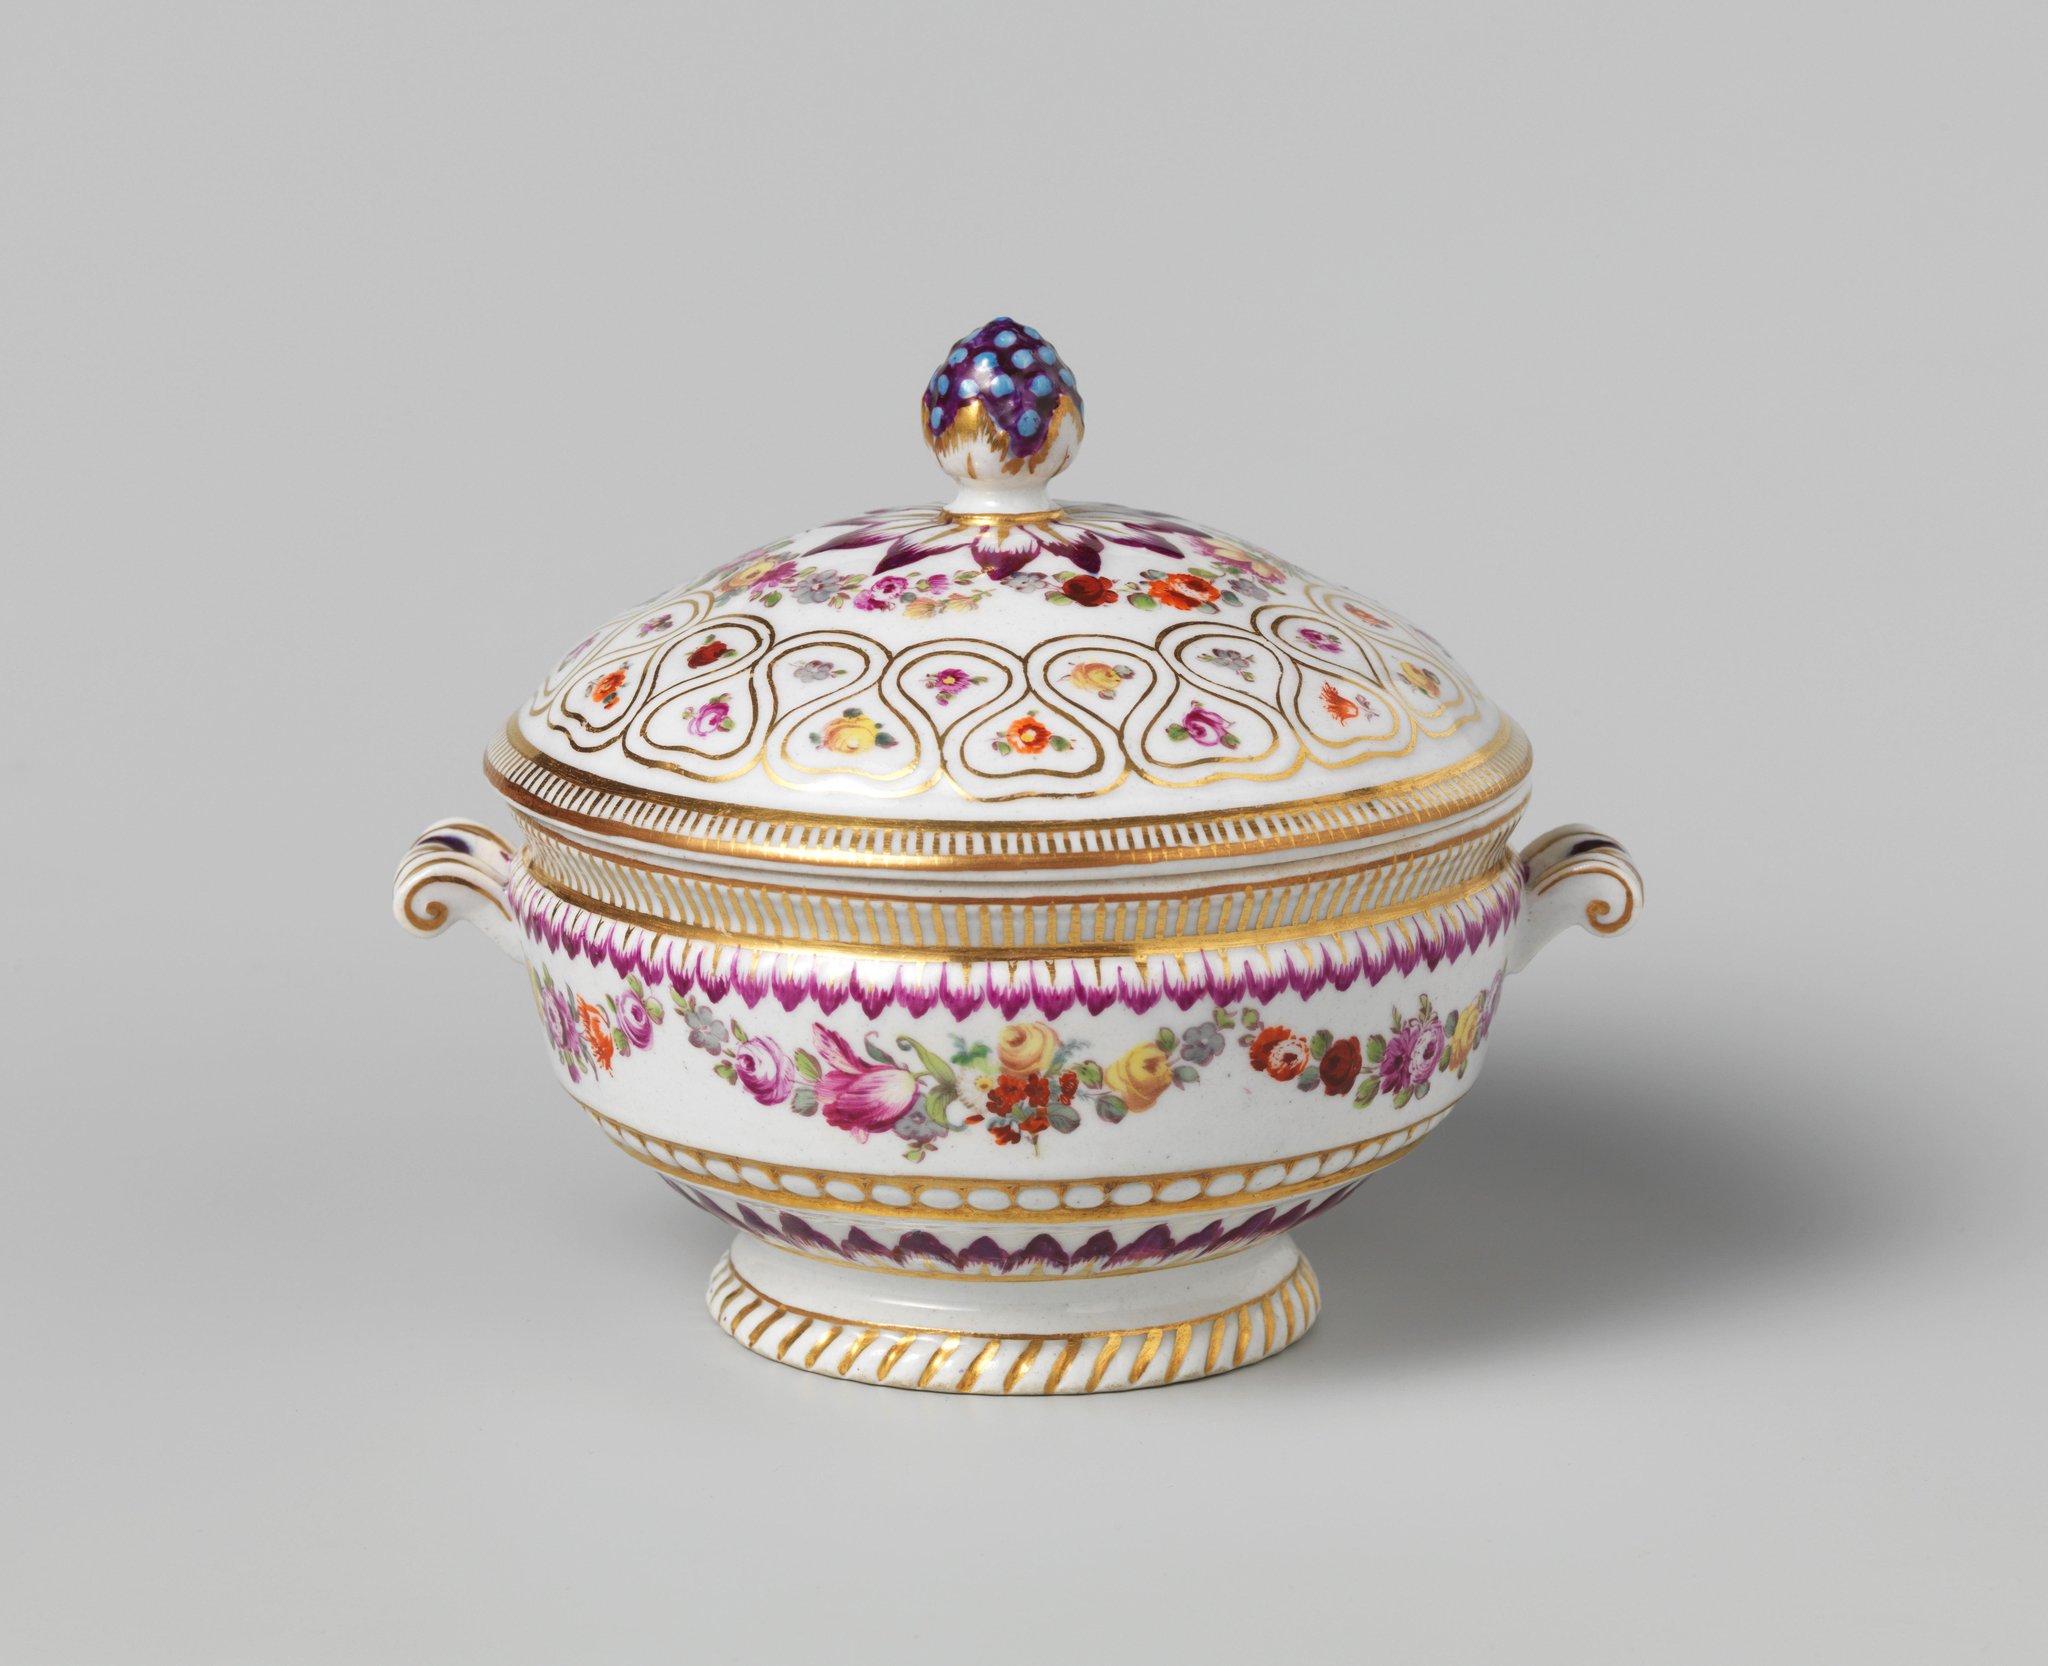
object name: sugar box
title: Suikerpot beschilderd met guirlandes en bloemen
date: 1778-1782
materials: porcelain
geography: loosdrecht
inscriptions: mark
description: Sugar bowl. Porcelain. Loosdrecht, c. 1778 - 1782. Factory of Joannes de Mol.